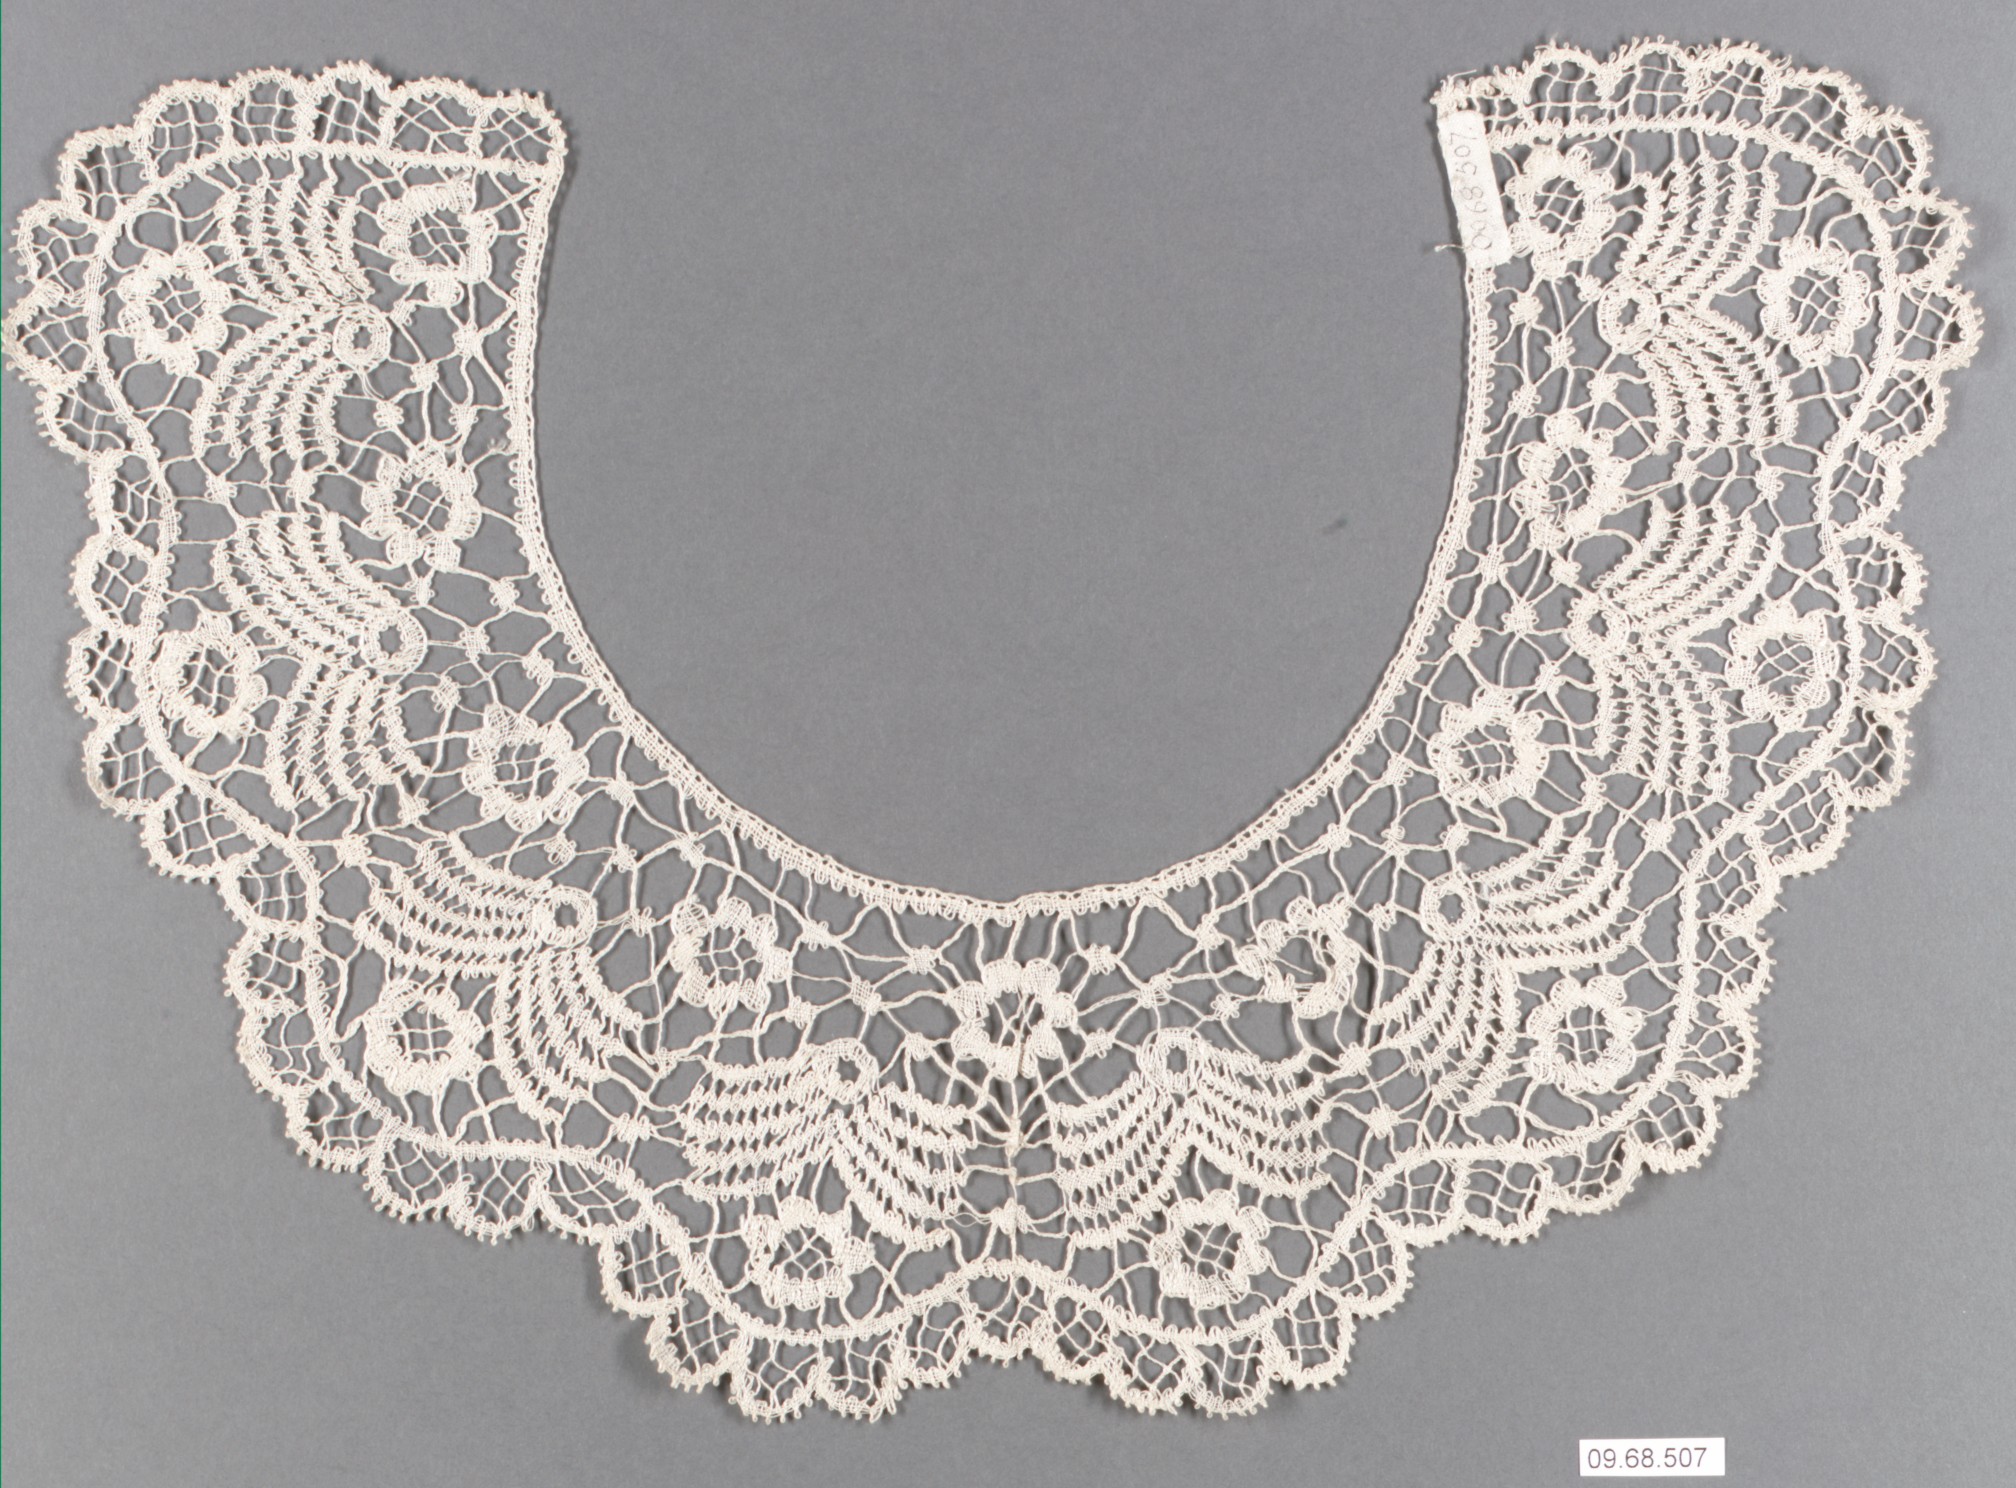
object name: collar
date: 1801-1900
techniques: lace